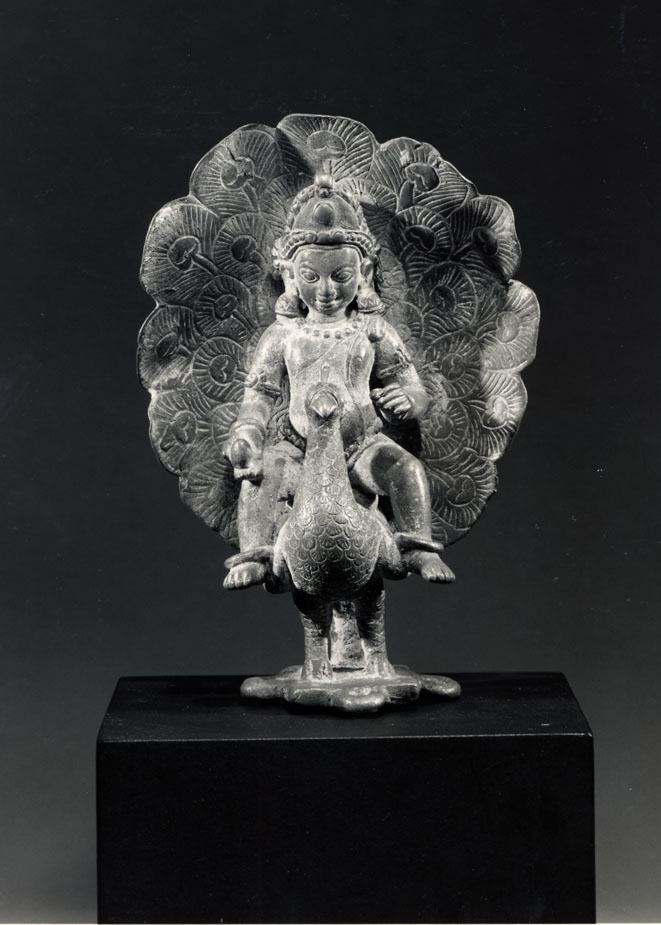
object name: figure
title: Kumara Riding a Peacock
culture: nepali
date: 1001-1200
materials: copper alloy, gilt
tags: peacocks,hinduism